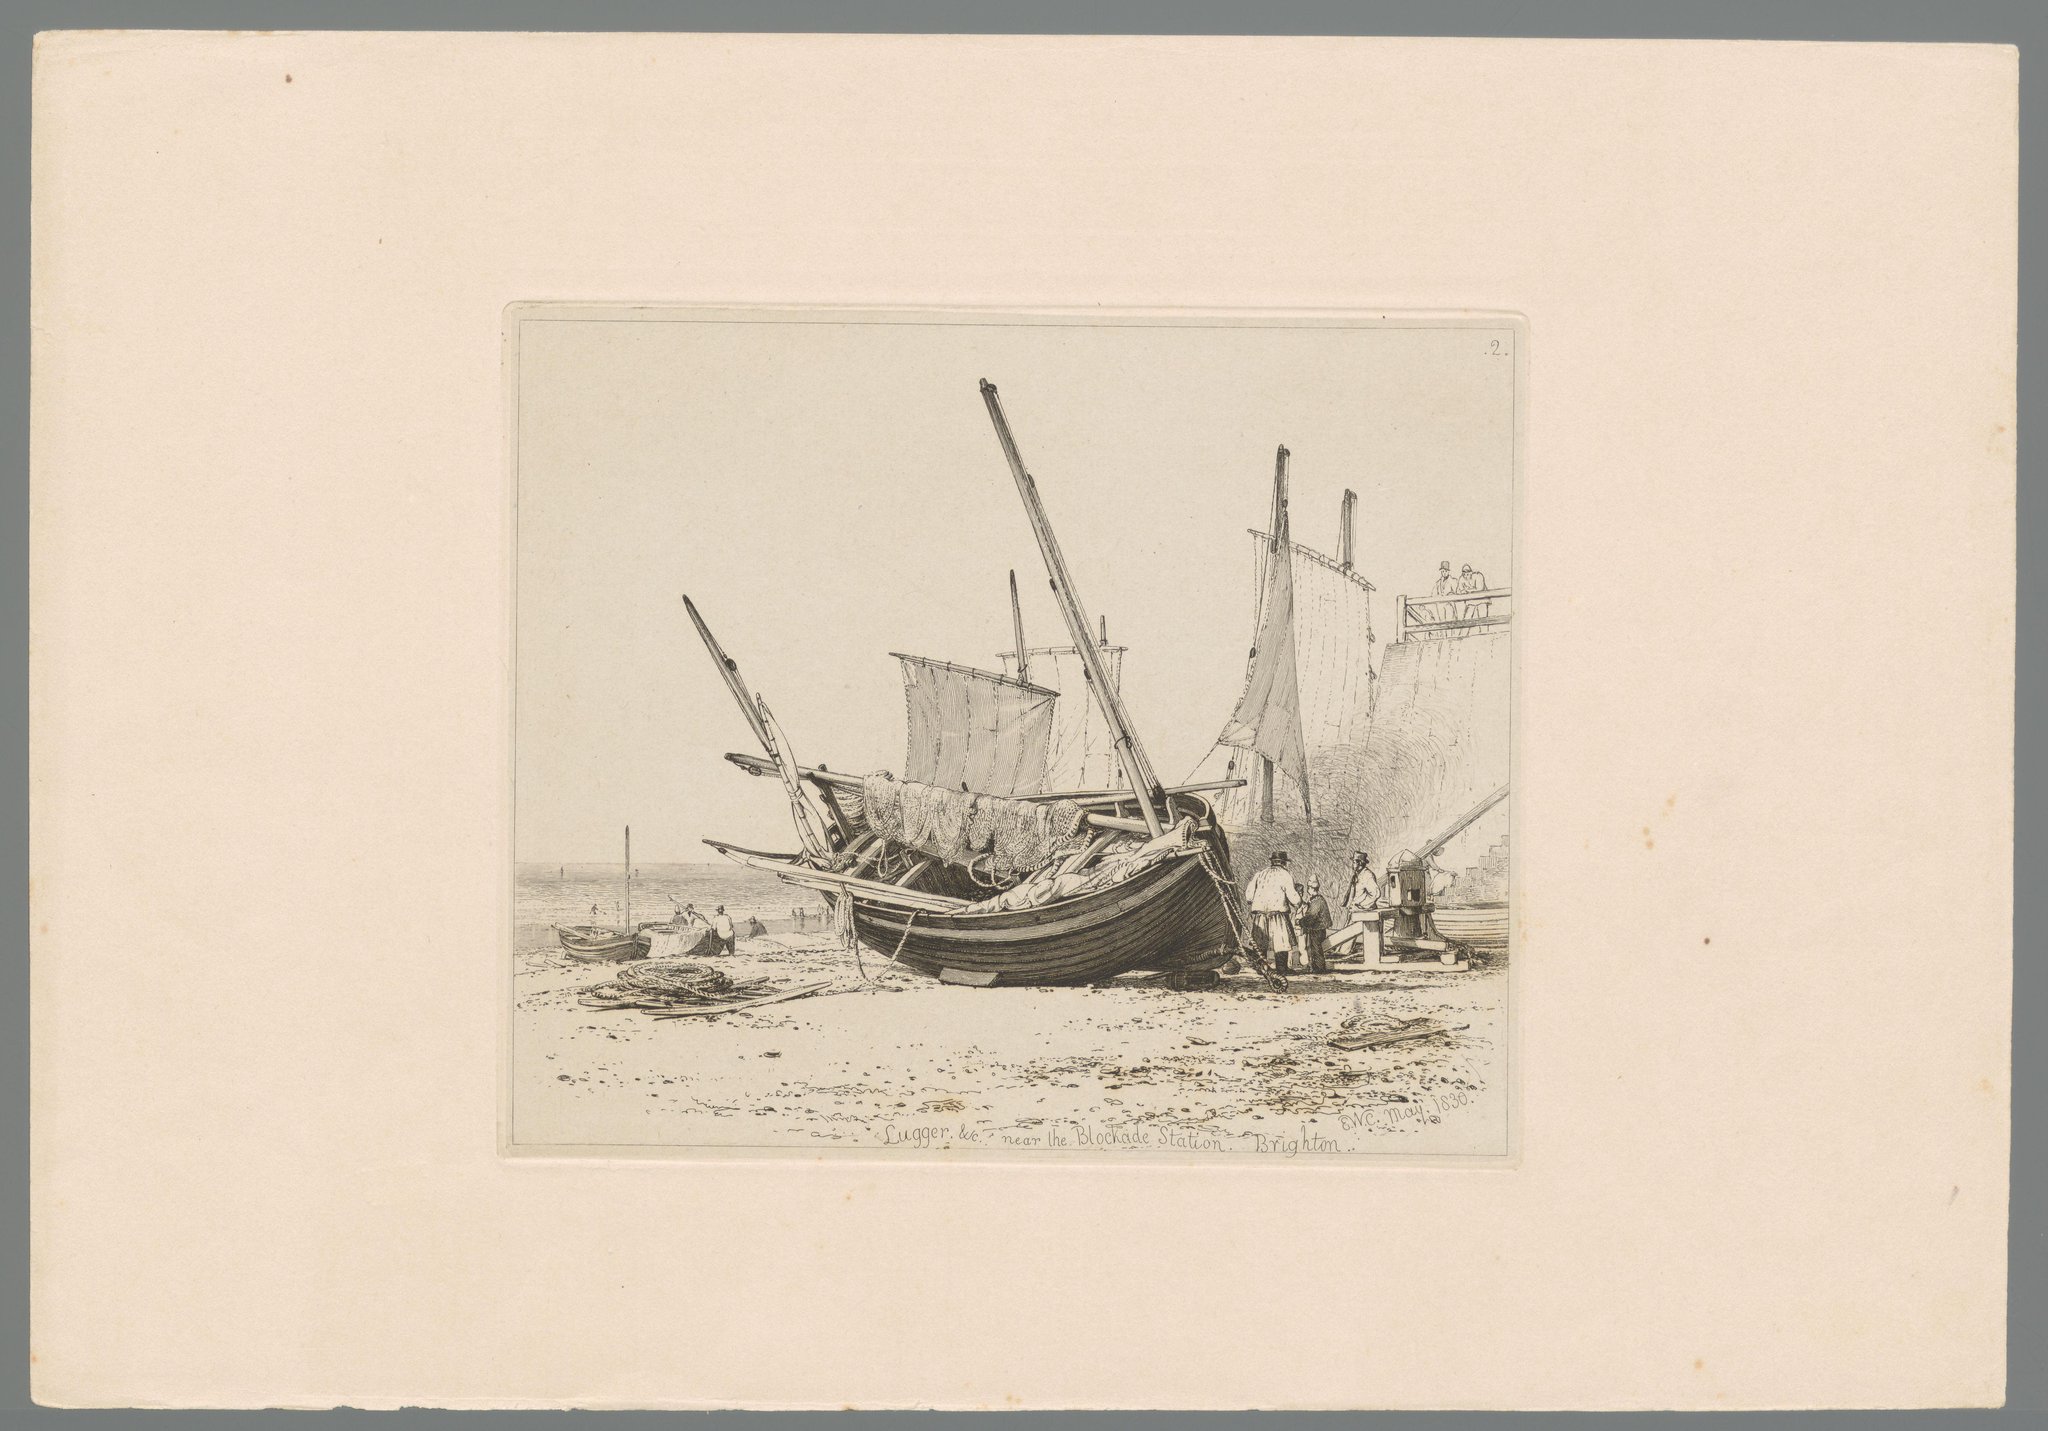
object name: print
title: Lugger &c. near the Blockade Station, Brighton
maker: edward william cooke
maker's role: print maker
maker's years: 1811-1880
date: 1805-1830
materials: paper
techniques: etching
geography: england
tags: sailing-ship, sailing-boat, beach (+ landscape with figures, staffage)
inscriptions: collector's mark: Lugt 2165